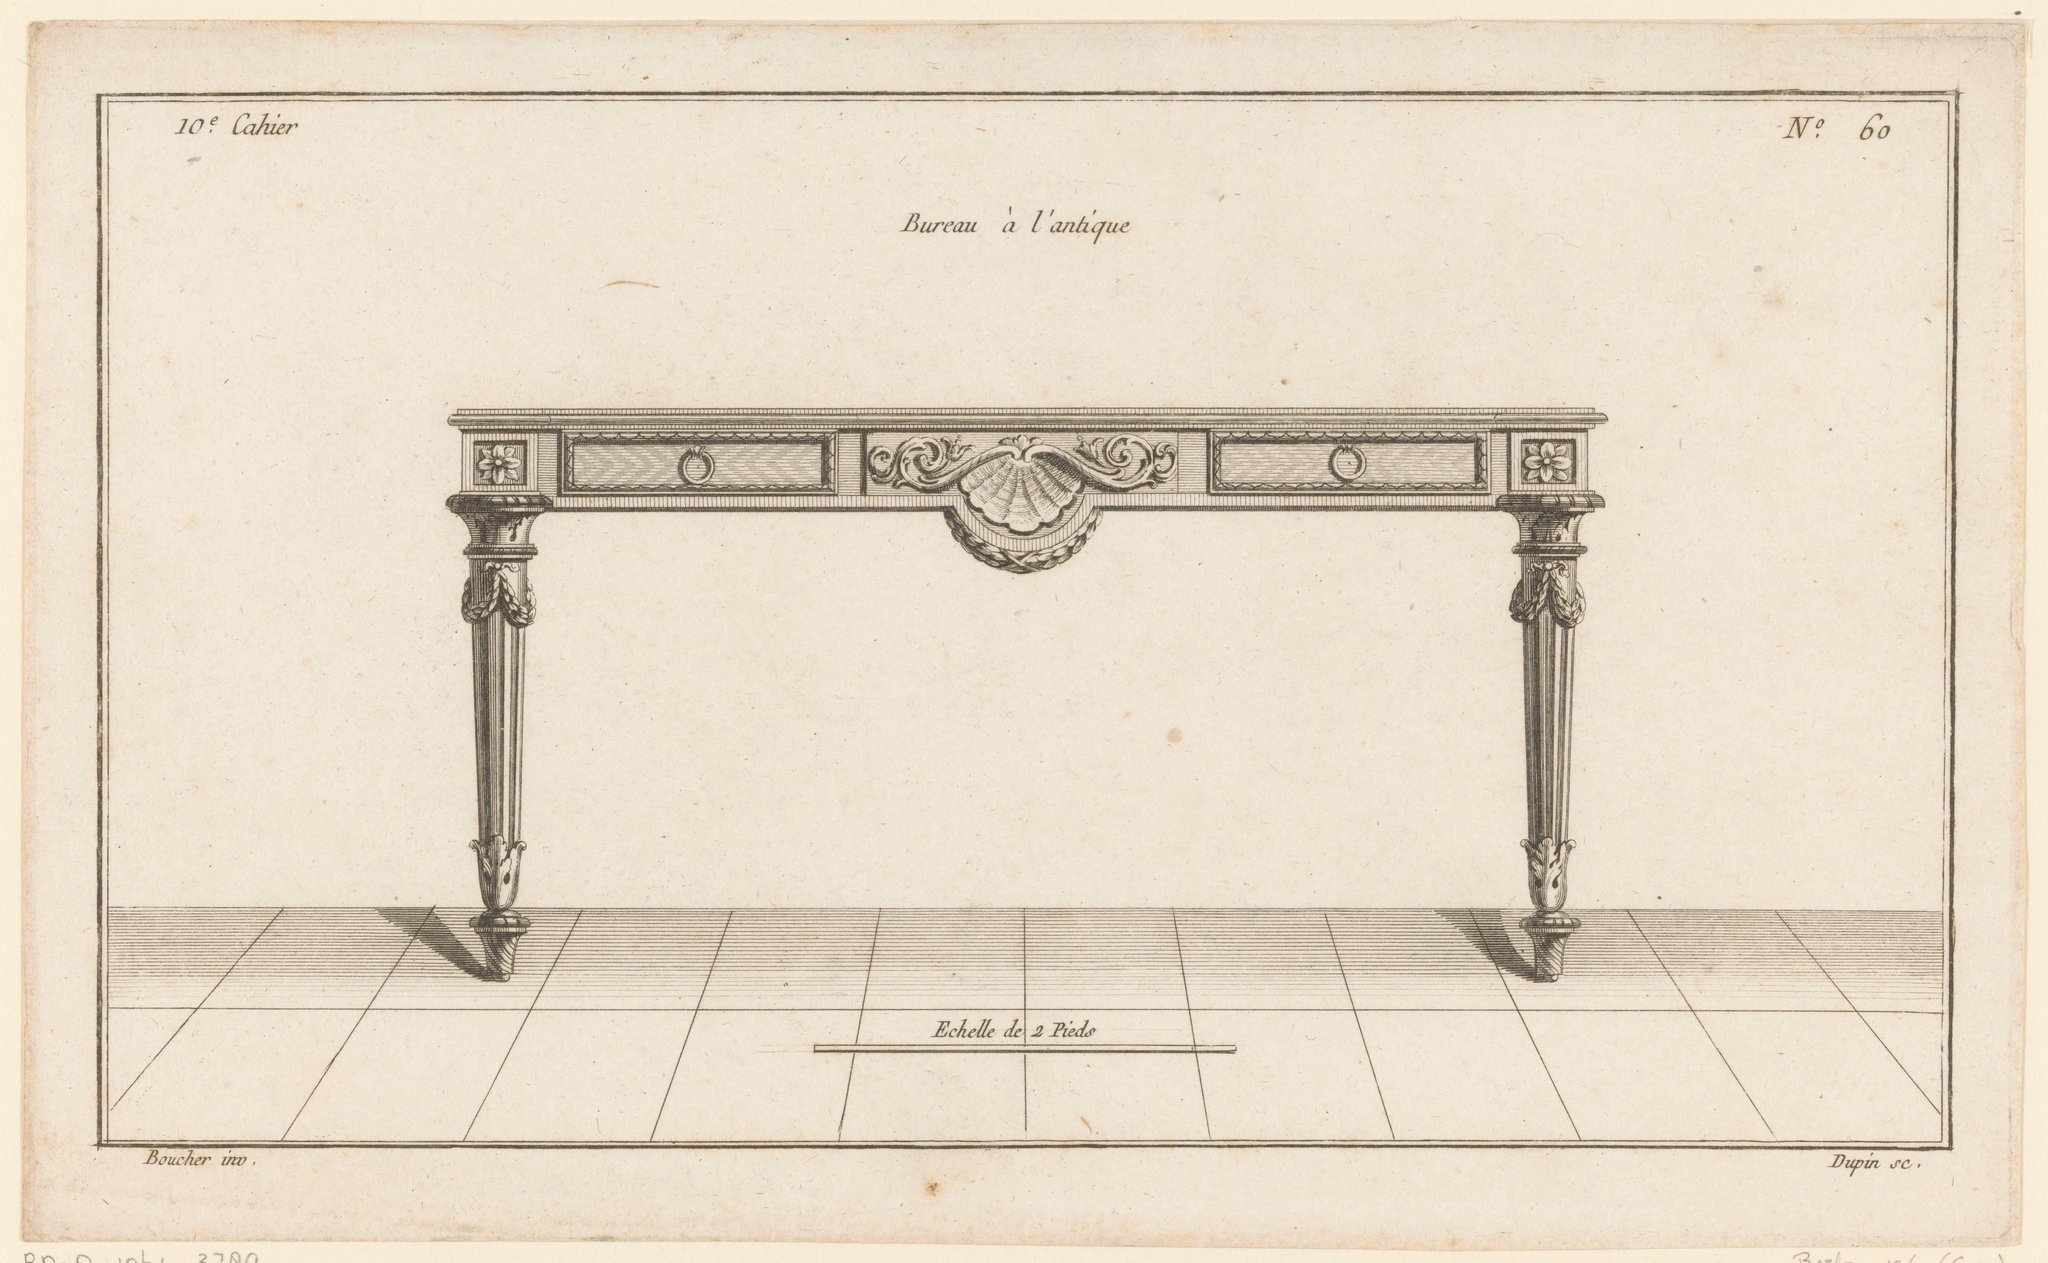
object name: ornament print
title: Secretaires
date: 1772-1779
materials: paper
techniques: engraving, etching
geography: paris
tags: writing-table, writing-desk, scallop, shell ~ ornament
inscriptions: collector's mark: Lugt 2760, collector's mark: Lugt 2228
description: Een geornamenteerd bureau met schelp- en bloemmotief. Prentnummer 60.